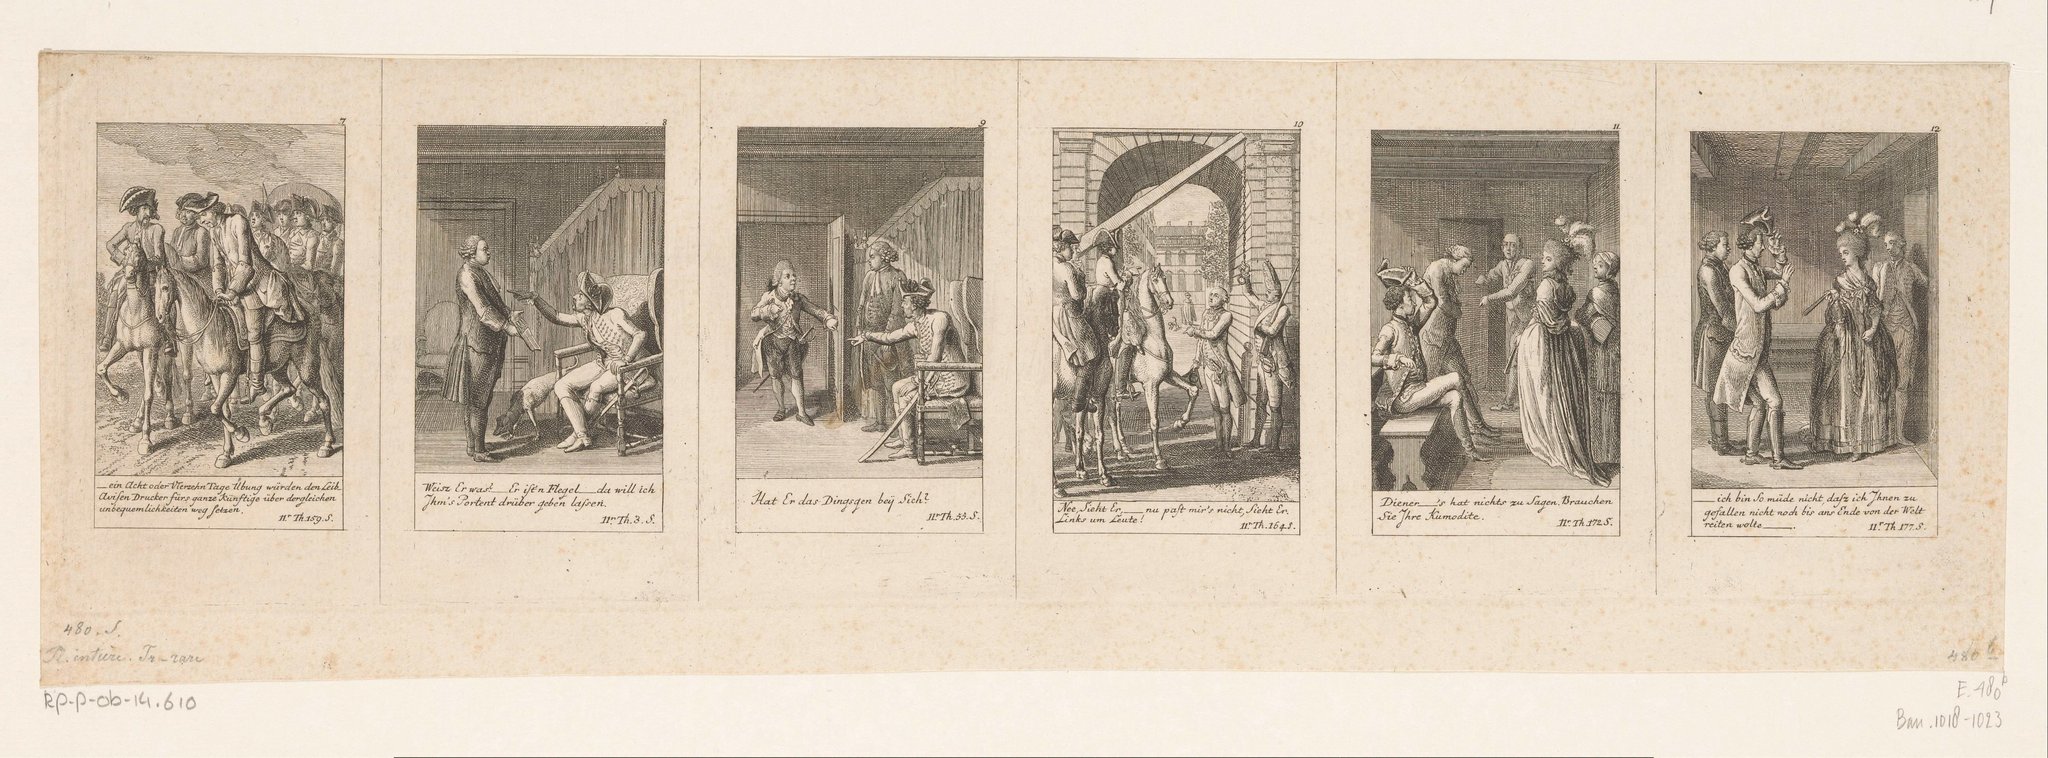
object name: print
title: Zes voorstellingen uit Müller's Siegfried von Lindenberg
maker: daniel nikolaus chodowiecki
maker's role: draughtsman, print maker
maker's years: 1726-1801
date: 1783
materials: paper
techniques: etching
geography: berlin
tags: city-view, and landscape with man-made constructions, literature, baring the head, lifting one's hat, book - mm - book open, interior of the house, disguise, horse, index finger forwards, pointing, indicating, dog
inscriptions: collector's mark: Lugt 2228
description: Zes voorstellingen op één plaat. Vervaardigd voor J. G. Müller's 'Siegfried von Lindenberg'. Een latere staat gebruikt in: Goettinger Taschen Calender vom Jahr 1784. bey Joh. Chr. Dietrich. Göttingen: Georg Christoph Lichtenberg, 1784.